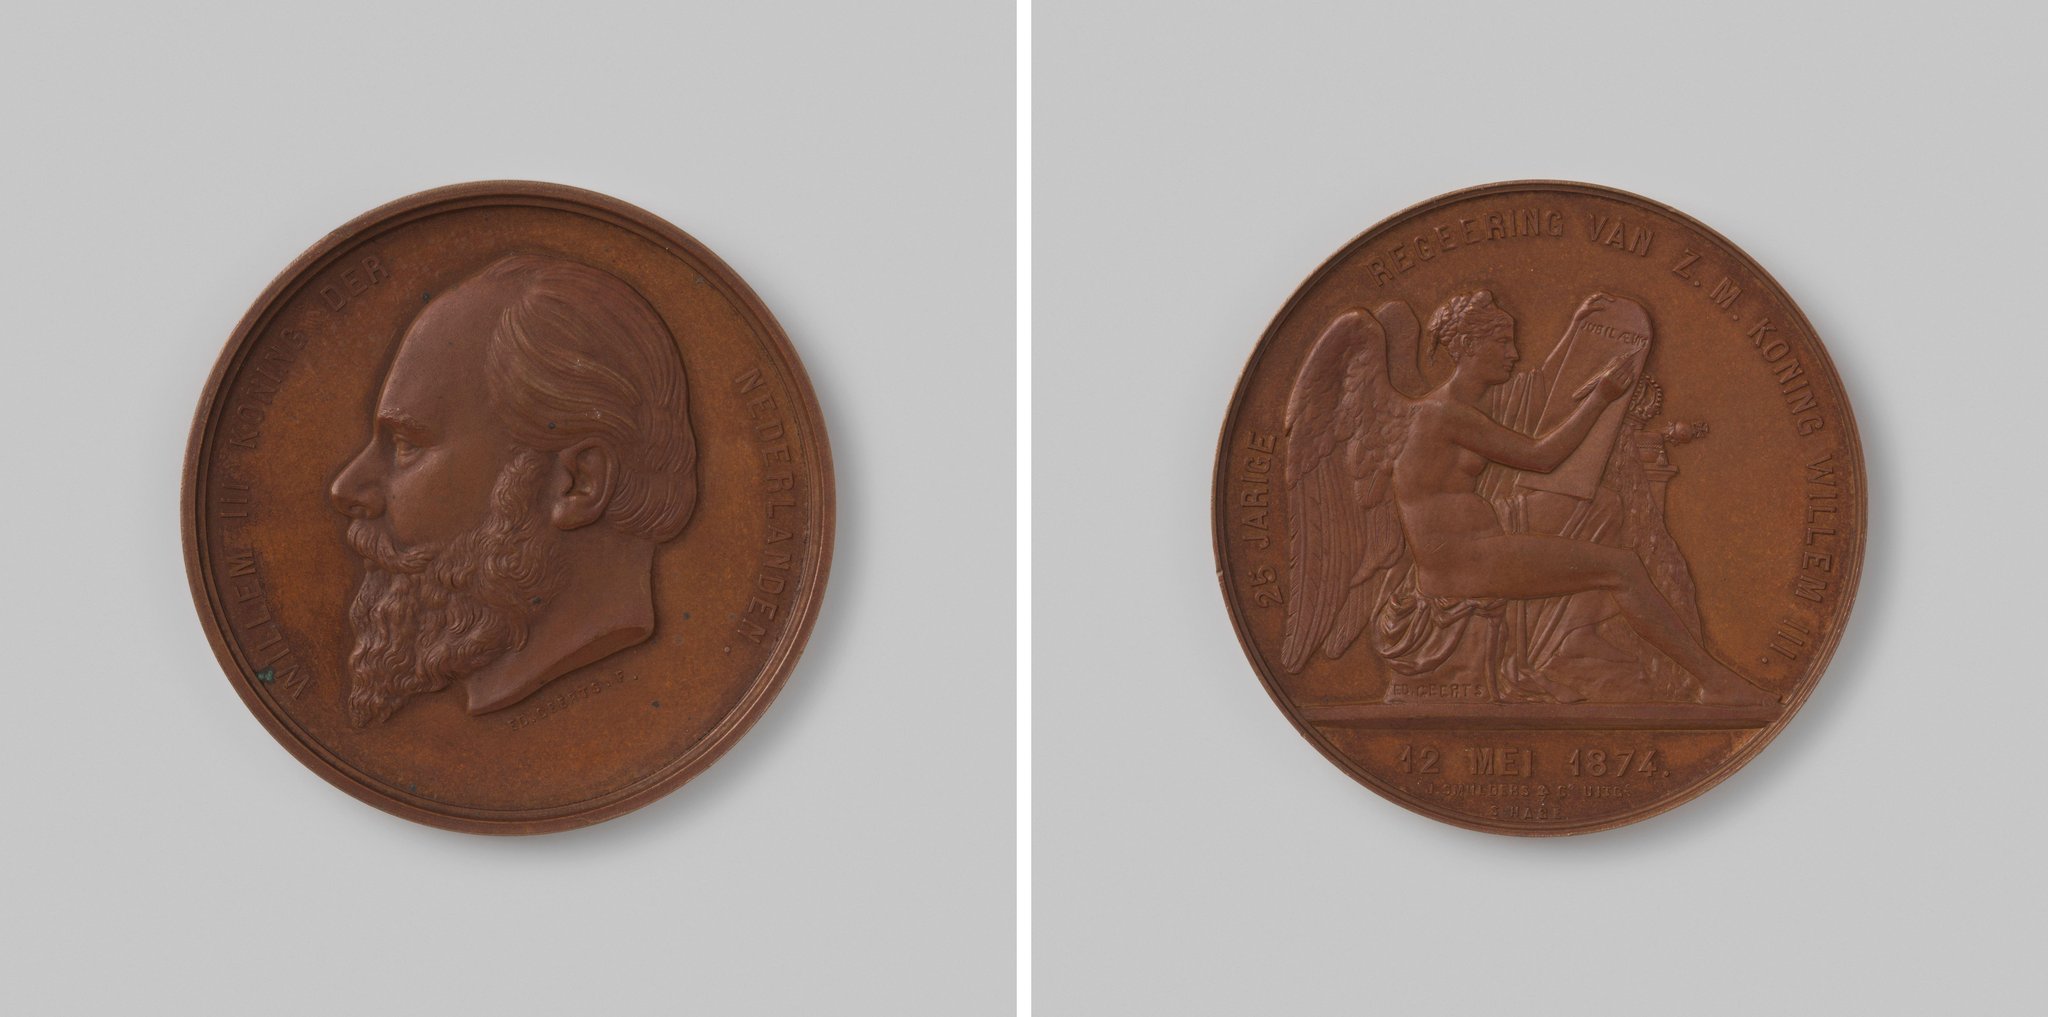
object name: history medal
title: Vijfentwintigjarig regeringsjubileum van Koning Willem III 1874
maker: edouard louis geerts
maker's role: medailleur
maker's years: 1846-1889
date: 1874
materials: bronze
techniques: striking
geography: the hague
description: Bronzen penning, op de voorzijde het portret van Willem III naar links met omschrift, op de keerzijde de Geschiedenis als zittende gevleugelde vrouw schrijft het woord JUBILÆUM op een stenen tafel, met omschrift en afsnedetekst.